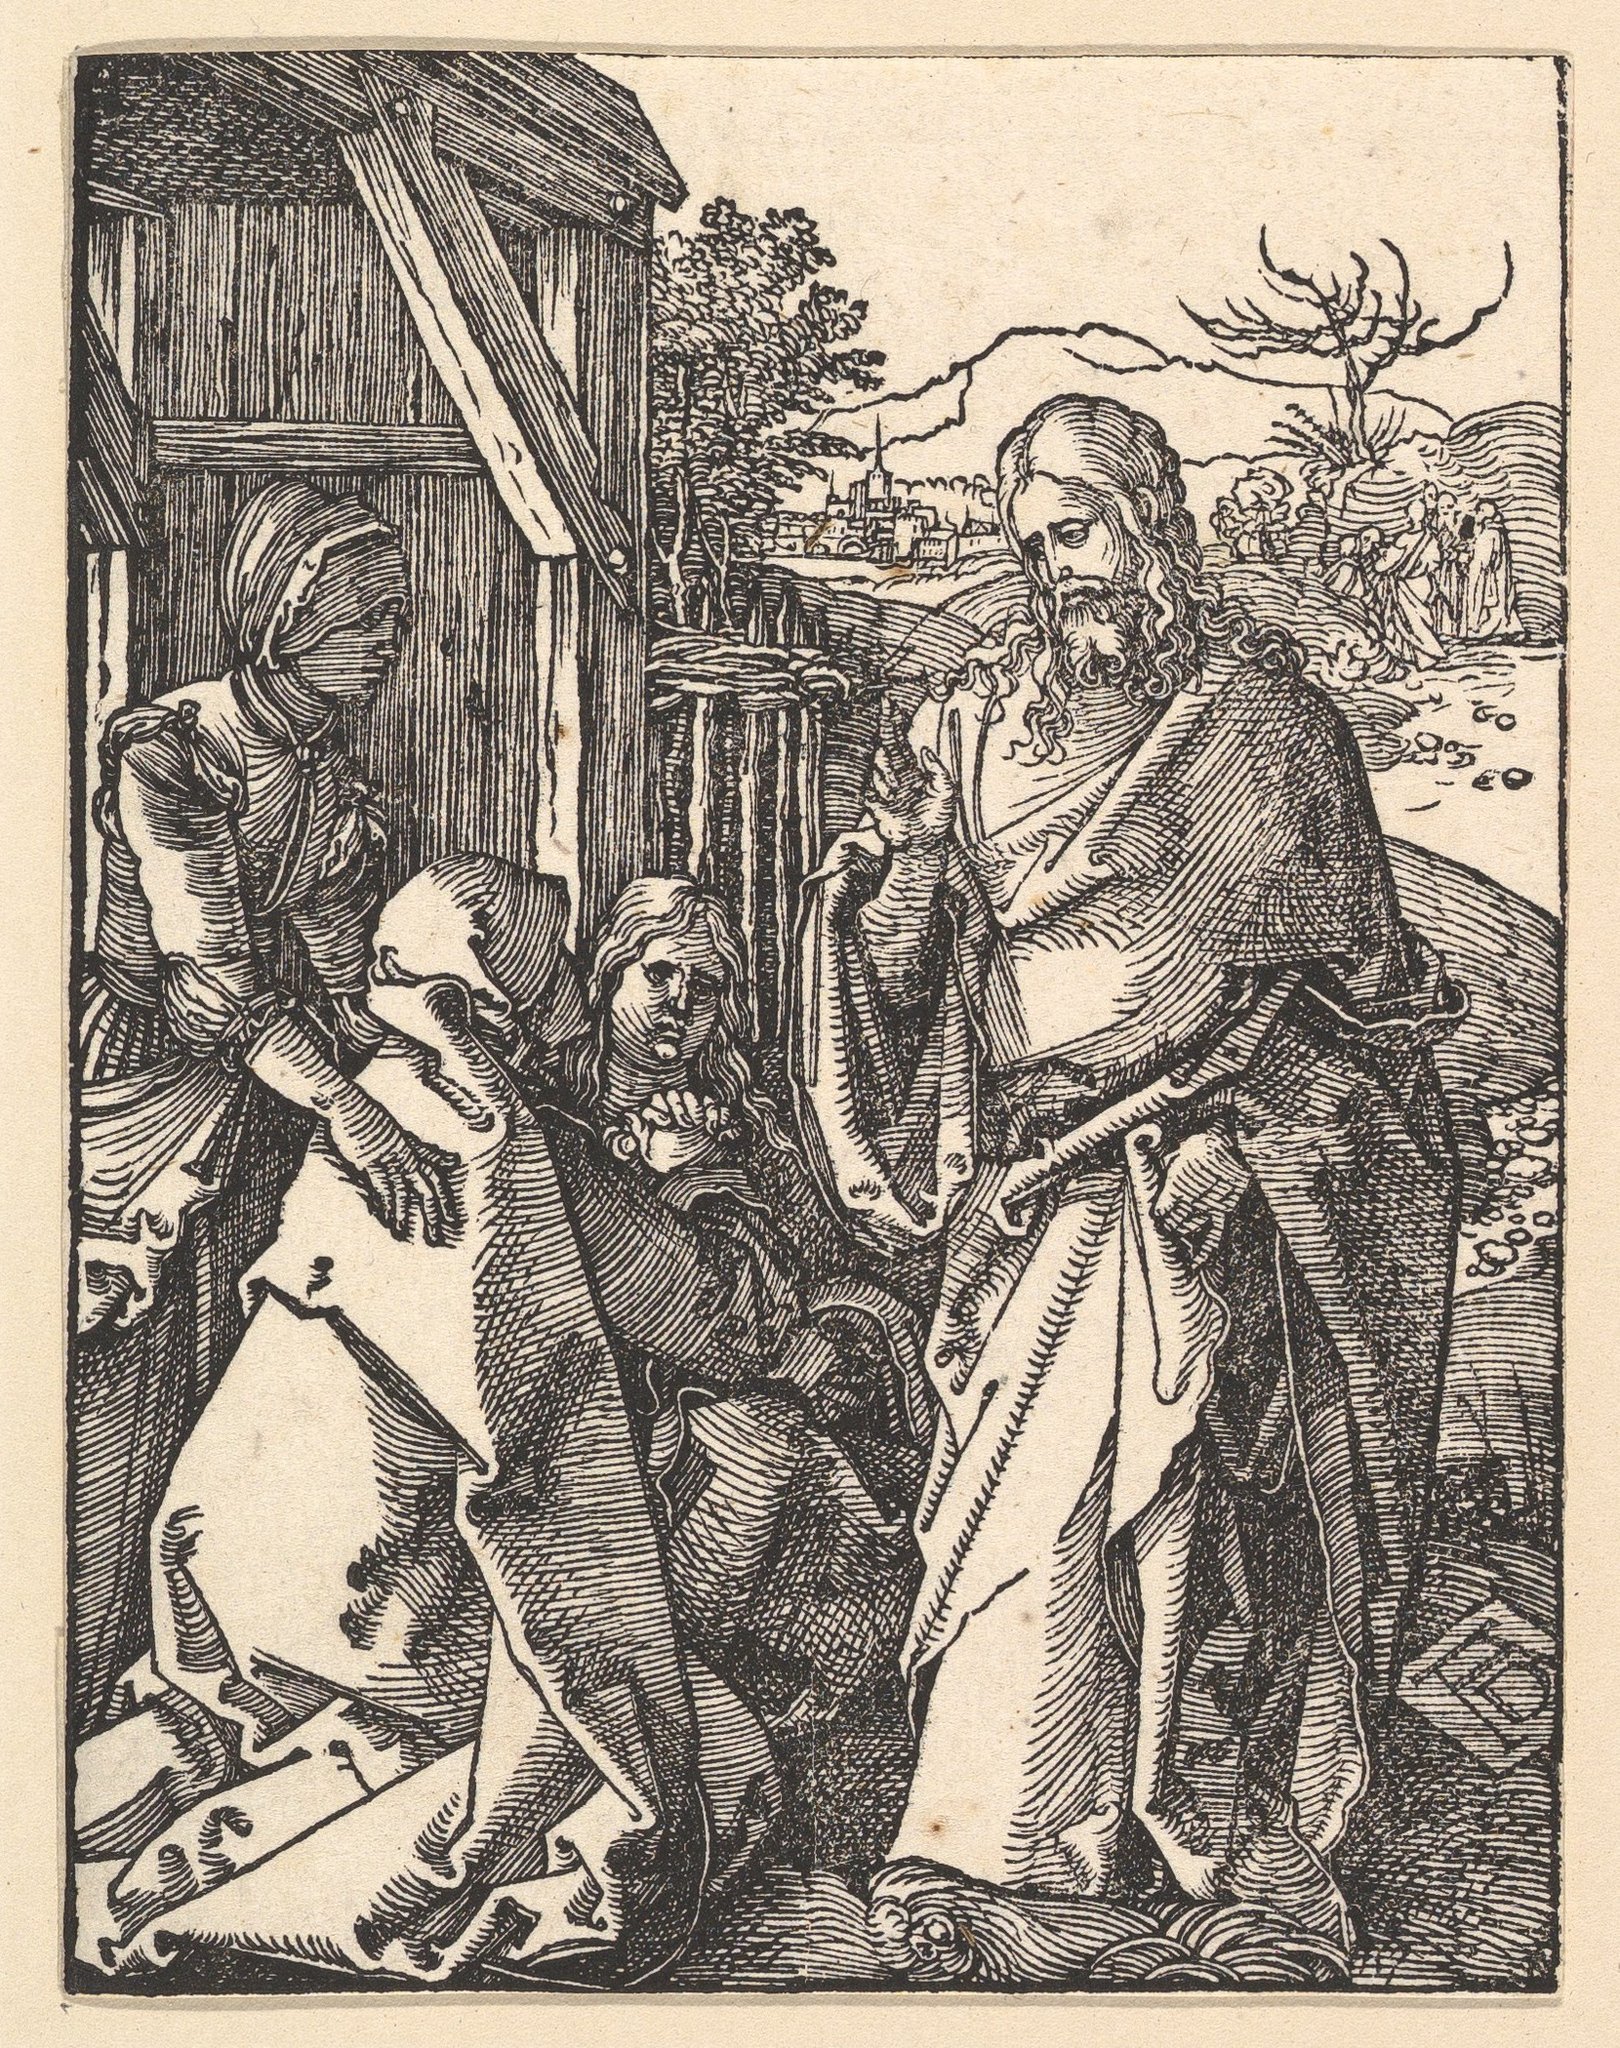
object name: print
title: Christ Taking Leave from his Mother, from "The Small Passion"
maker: albrecht dürer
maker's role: artist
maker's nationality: german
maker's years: 1471-1528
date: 1508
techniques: woodcut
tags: christ,virgin mary